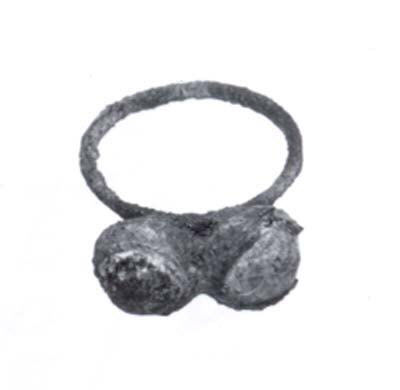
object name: ring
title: Finger ring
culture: sasanian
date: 201-700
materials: gold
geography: iran